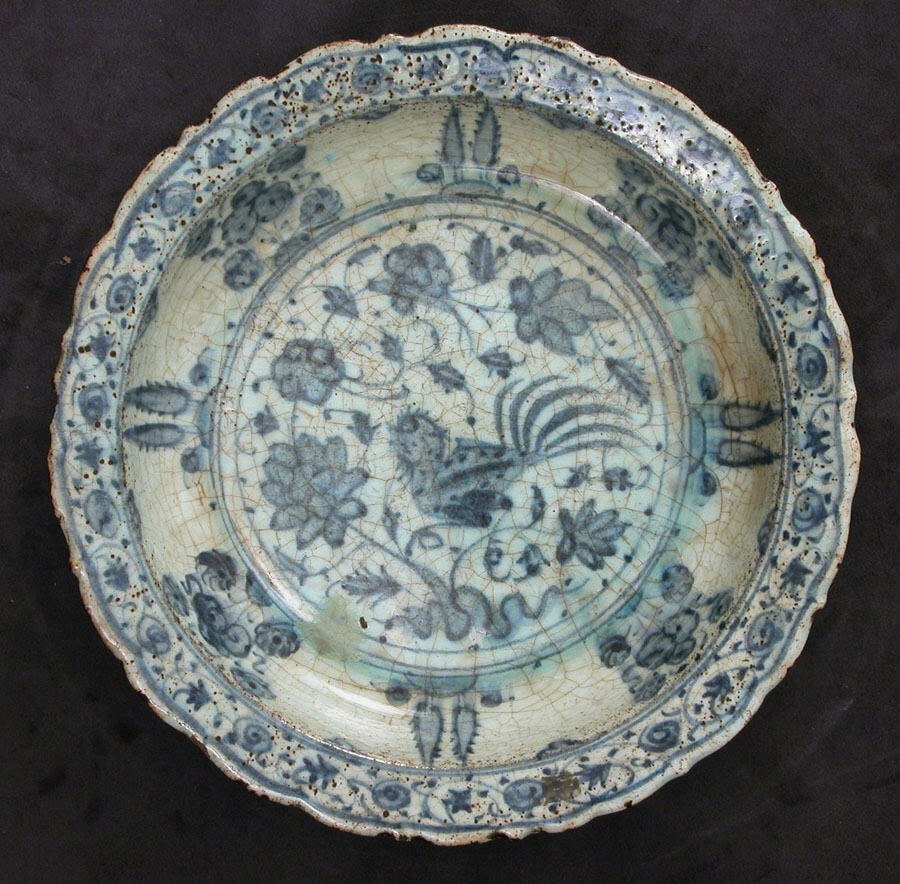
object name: plate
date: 1601-1700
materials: glaze, stonepaste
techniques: painting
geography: central asia